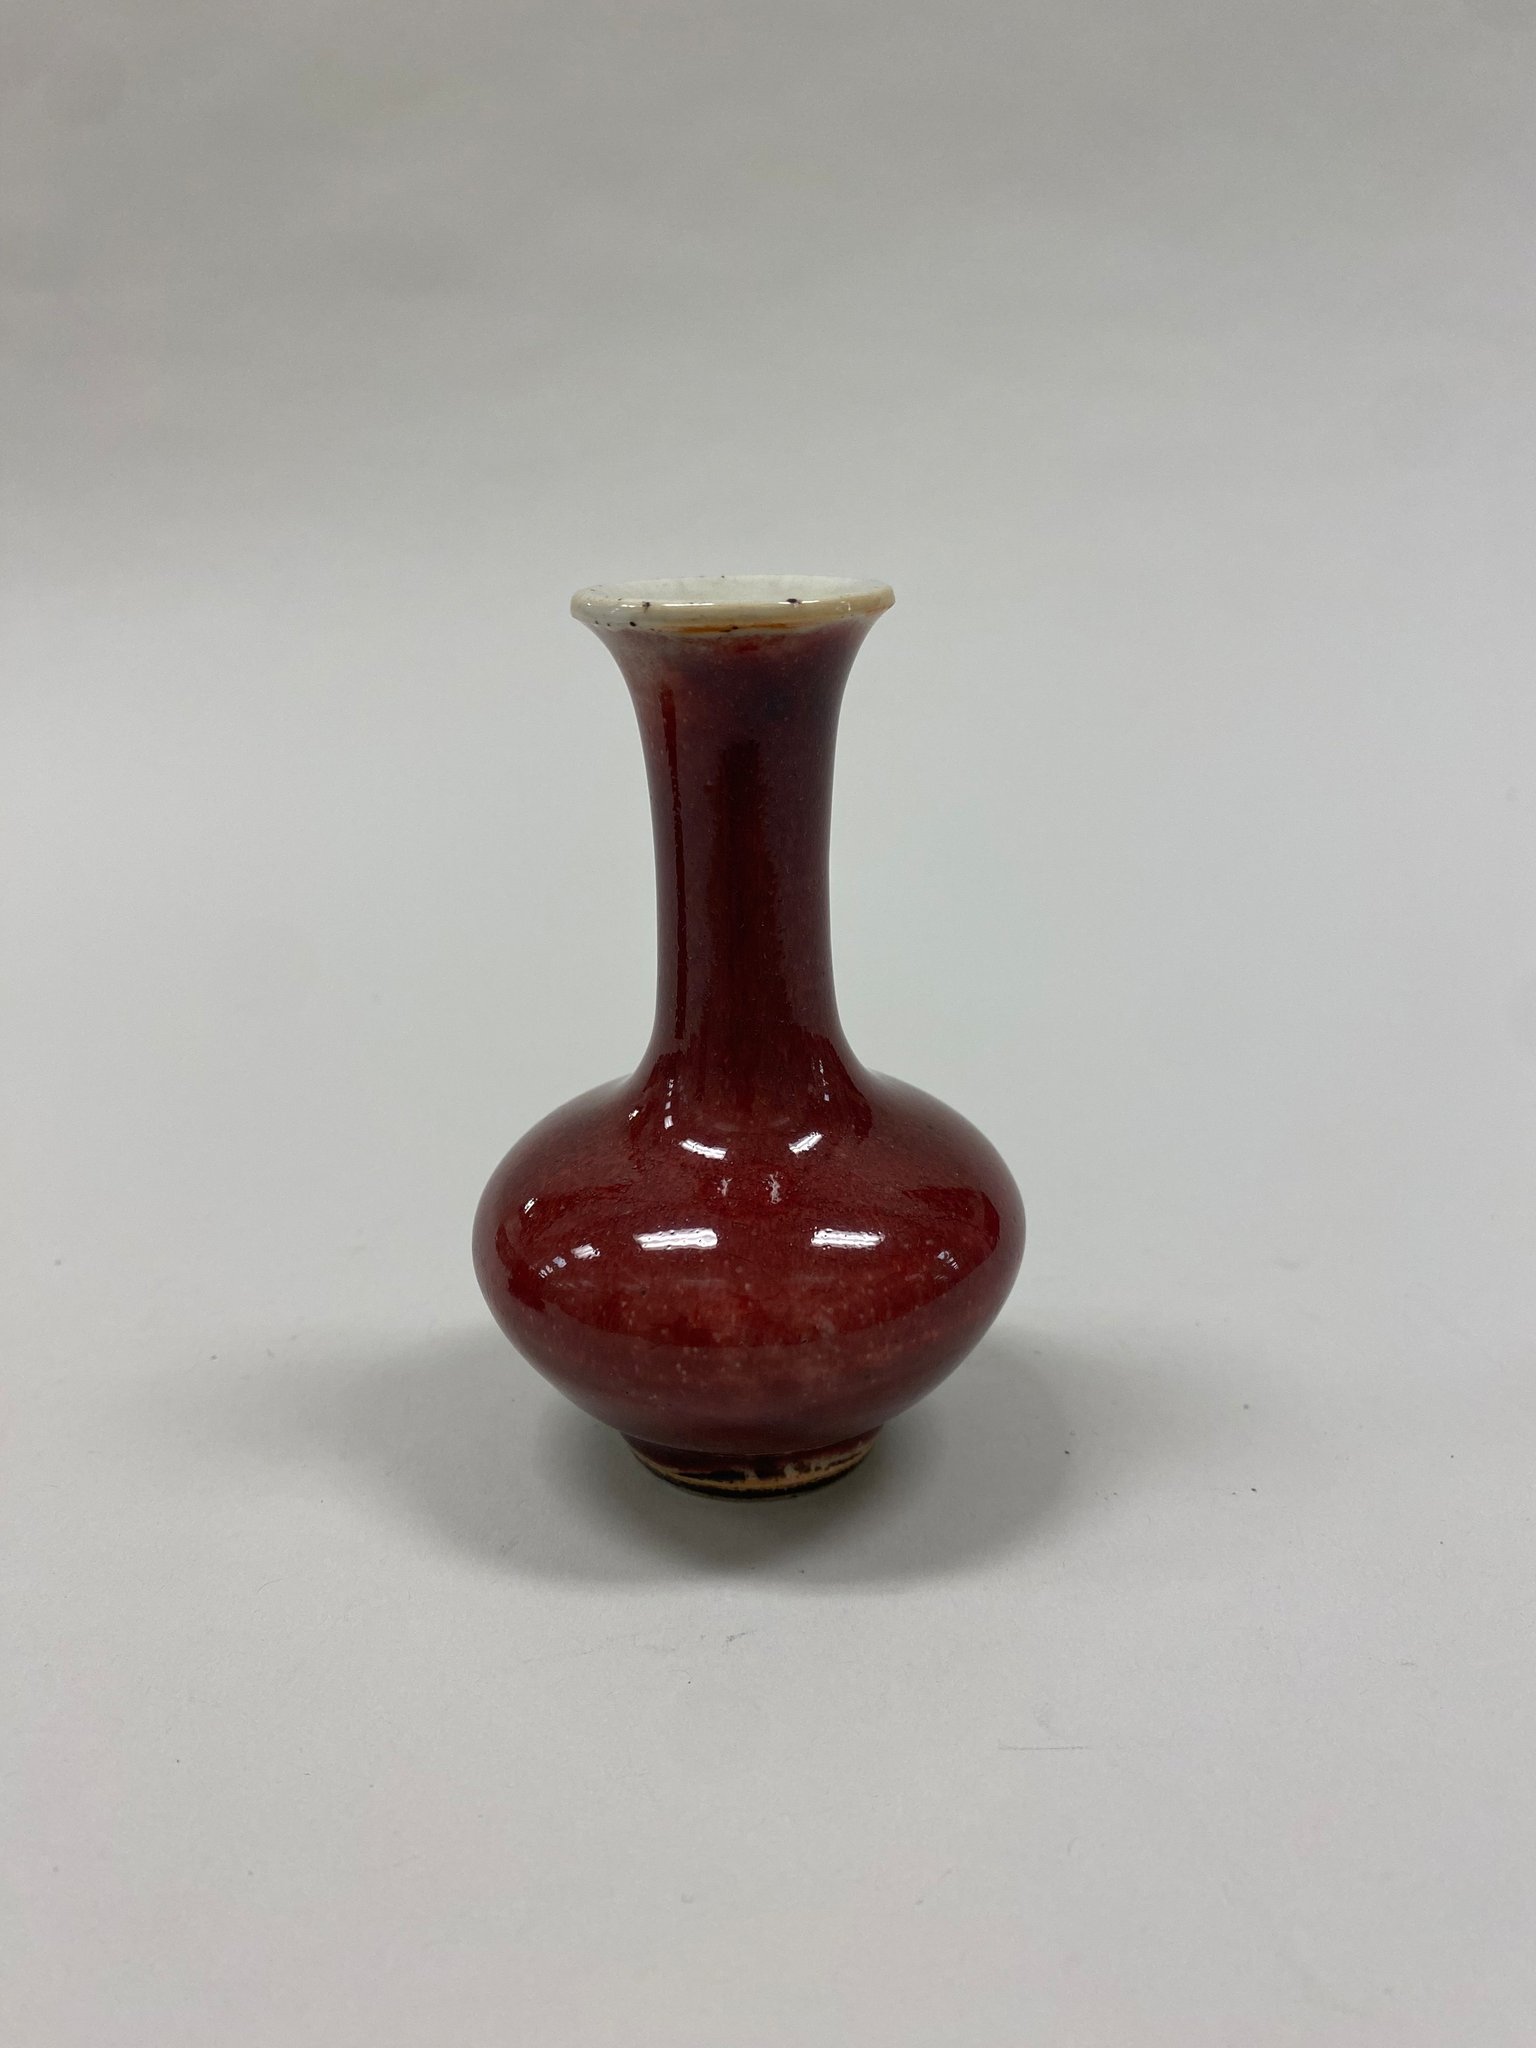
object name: vase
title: Minature vase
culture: chinese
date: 1701-1800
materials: copper, glaze, porcelain